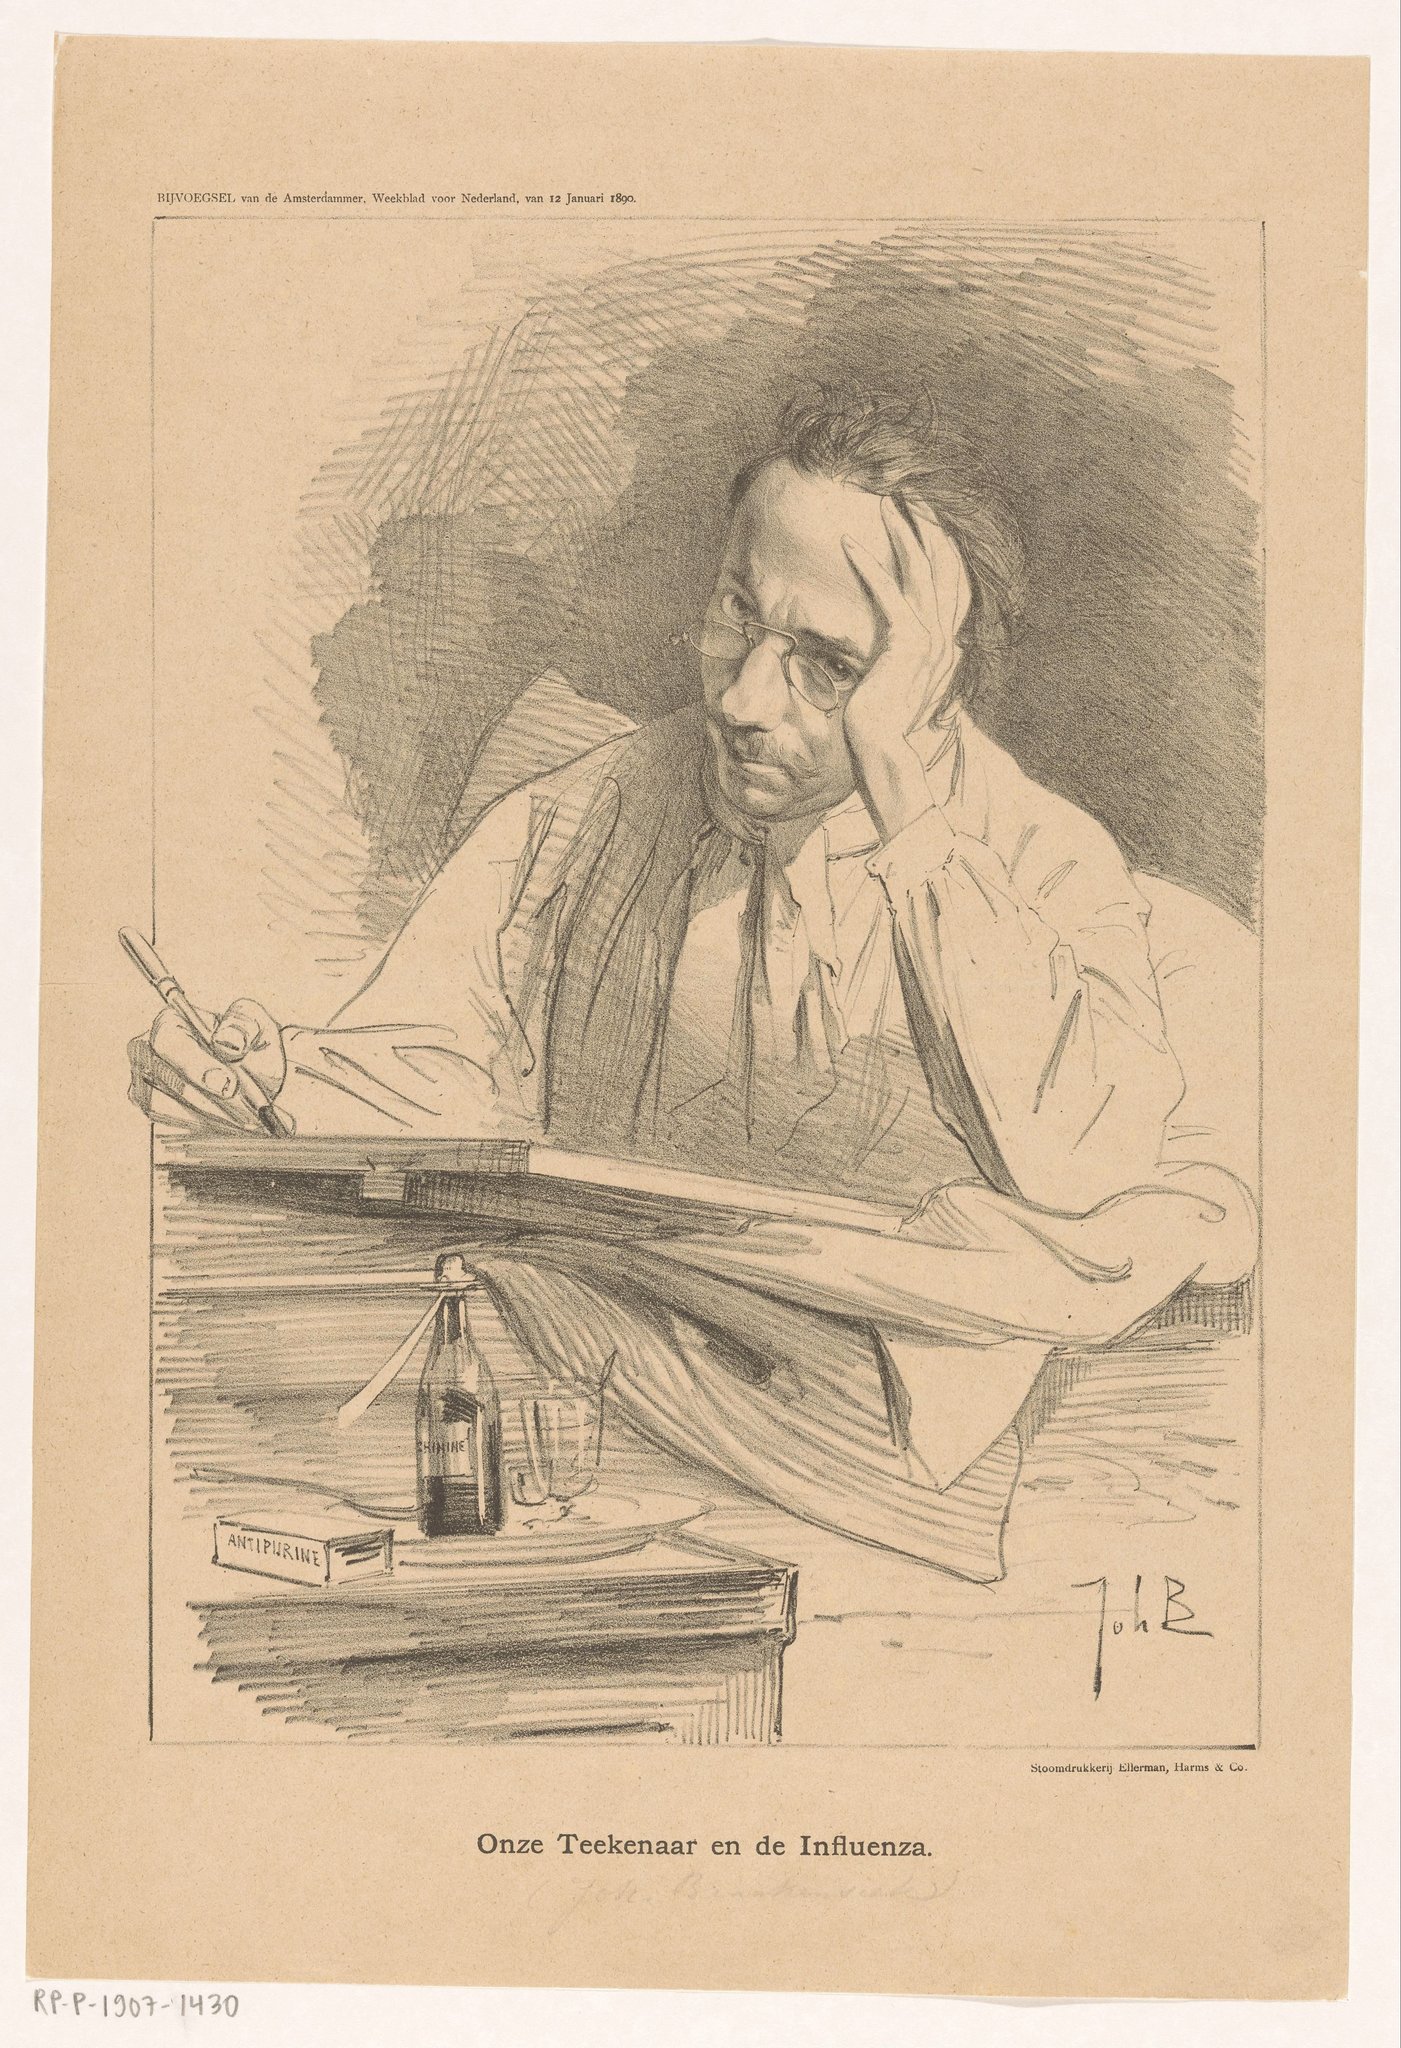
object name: print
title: Zelfportret van Johan Braakensiek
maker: johan braakensiek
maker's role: draughtsman, print maker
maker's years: 1858-1940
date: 1890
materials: paper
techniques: lithograph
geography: amsterdam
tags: amsterdam, print maker, draughtsman, johan braakensiek, sick-bed, portrait, self-portrait of graphic artist, medicament, medicine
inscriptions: collector's mark: Lugt 2228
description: Johan Braakensiek, met griep aan het werk in bed. Links op de voorgrond verpakkingen met antipyrine en chinine op een tafel.